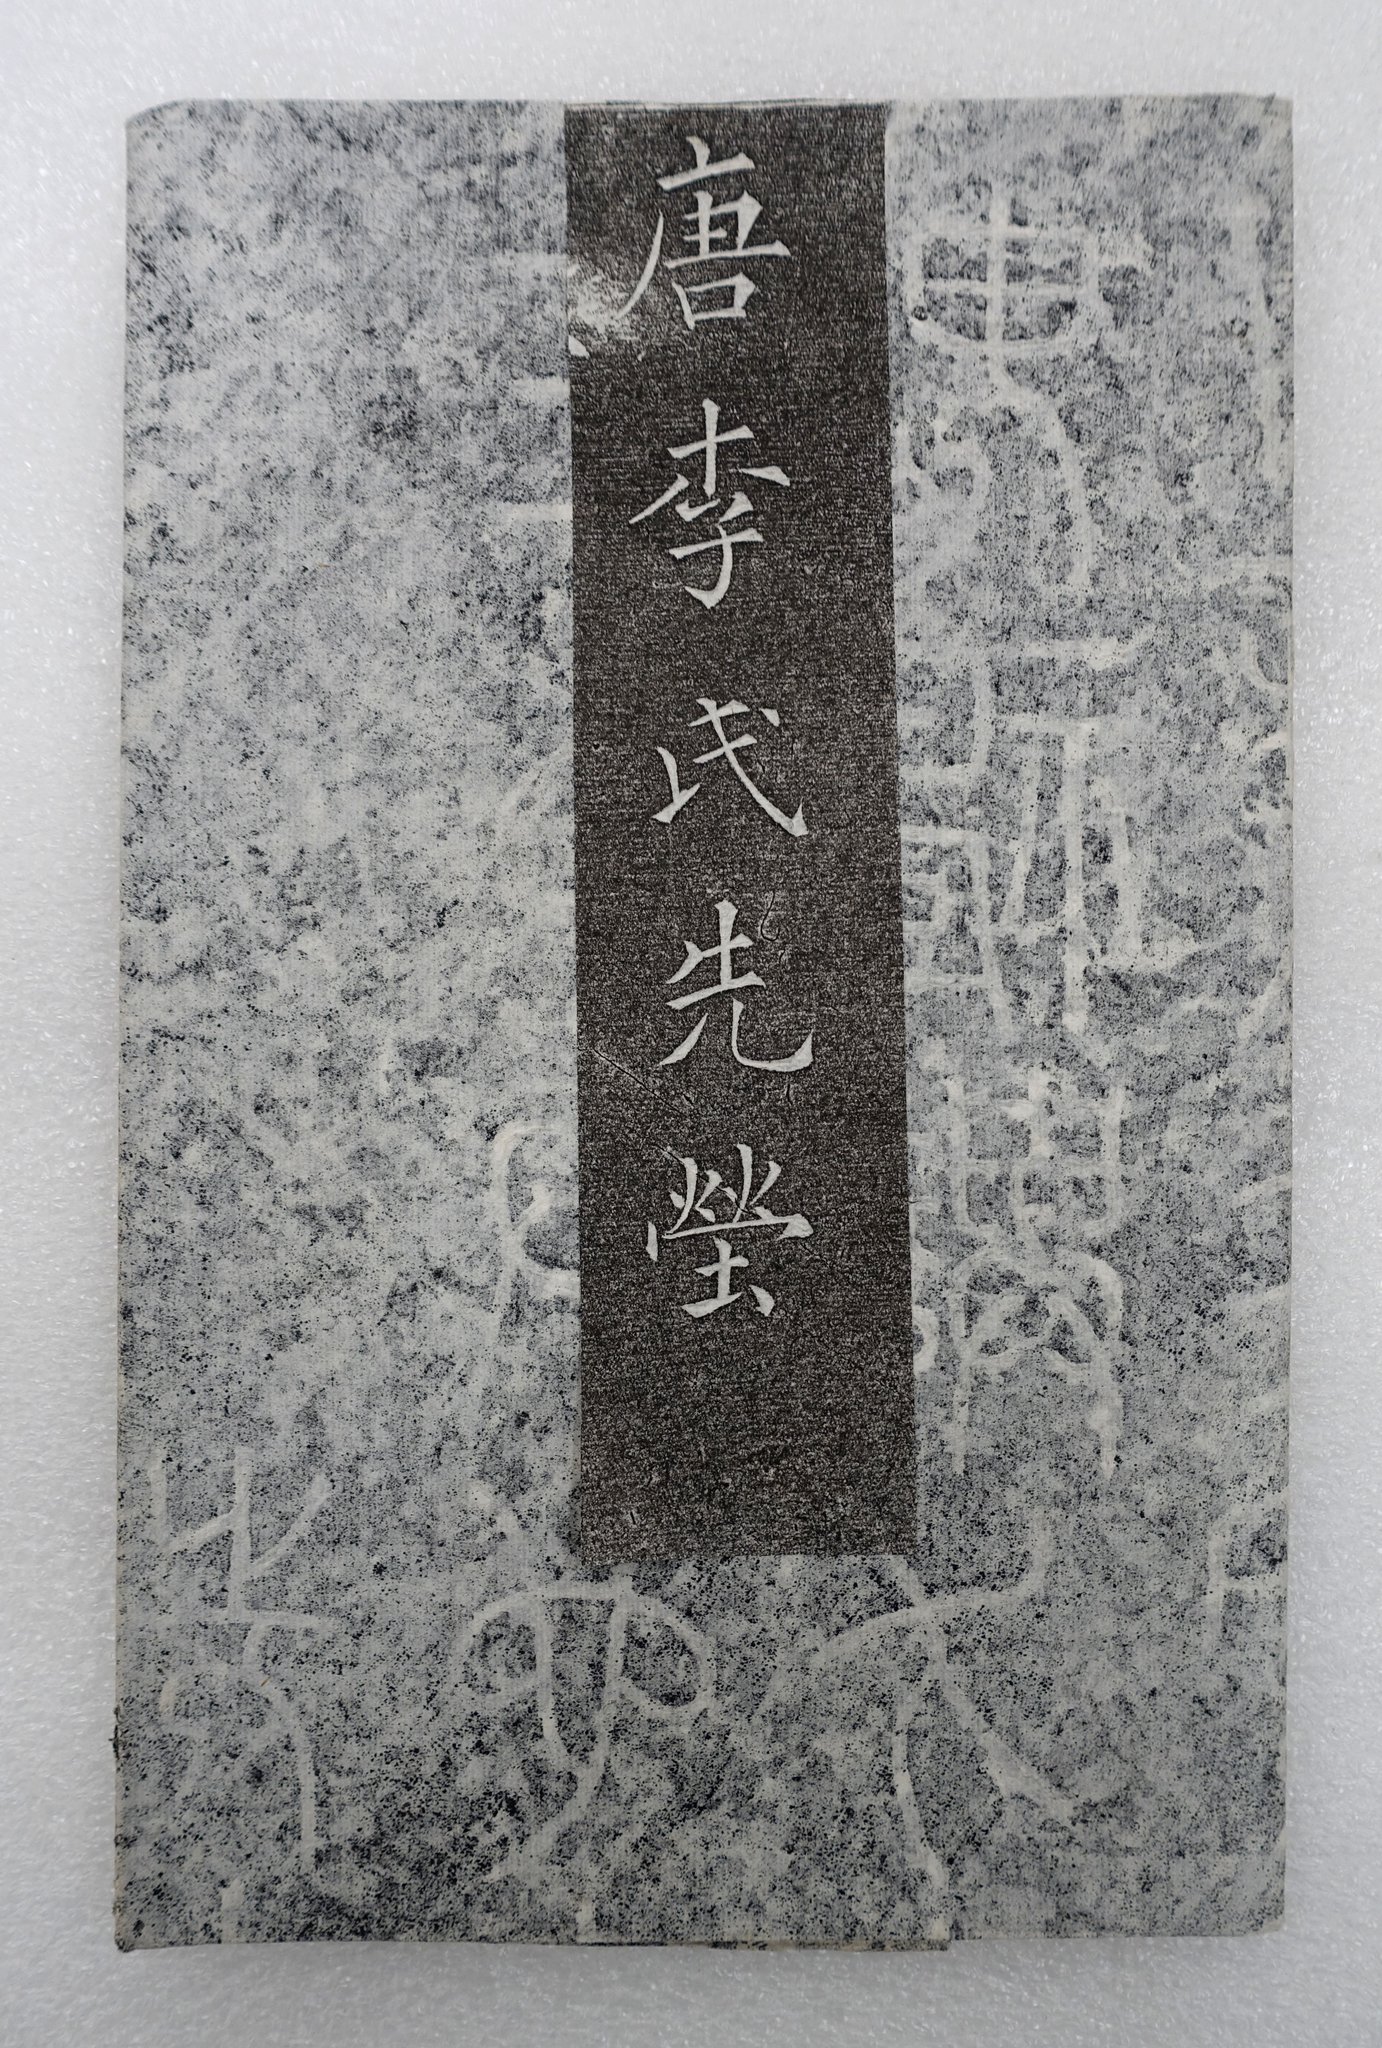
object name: rubbing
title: Xian Ying Ji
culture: chinese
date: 1901-2000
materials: ink, paper